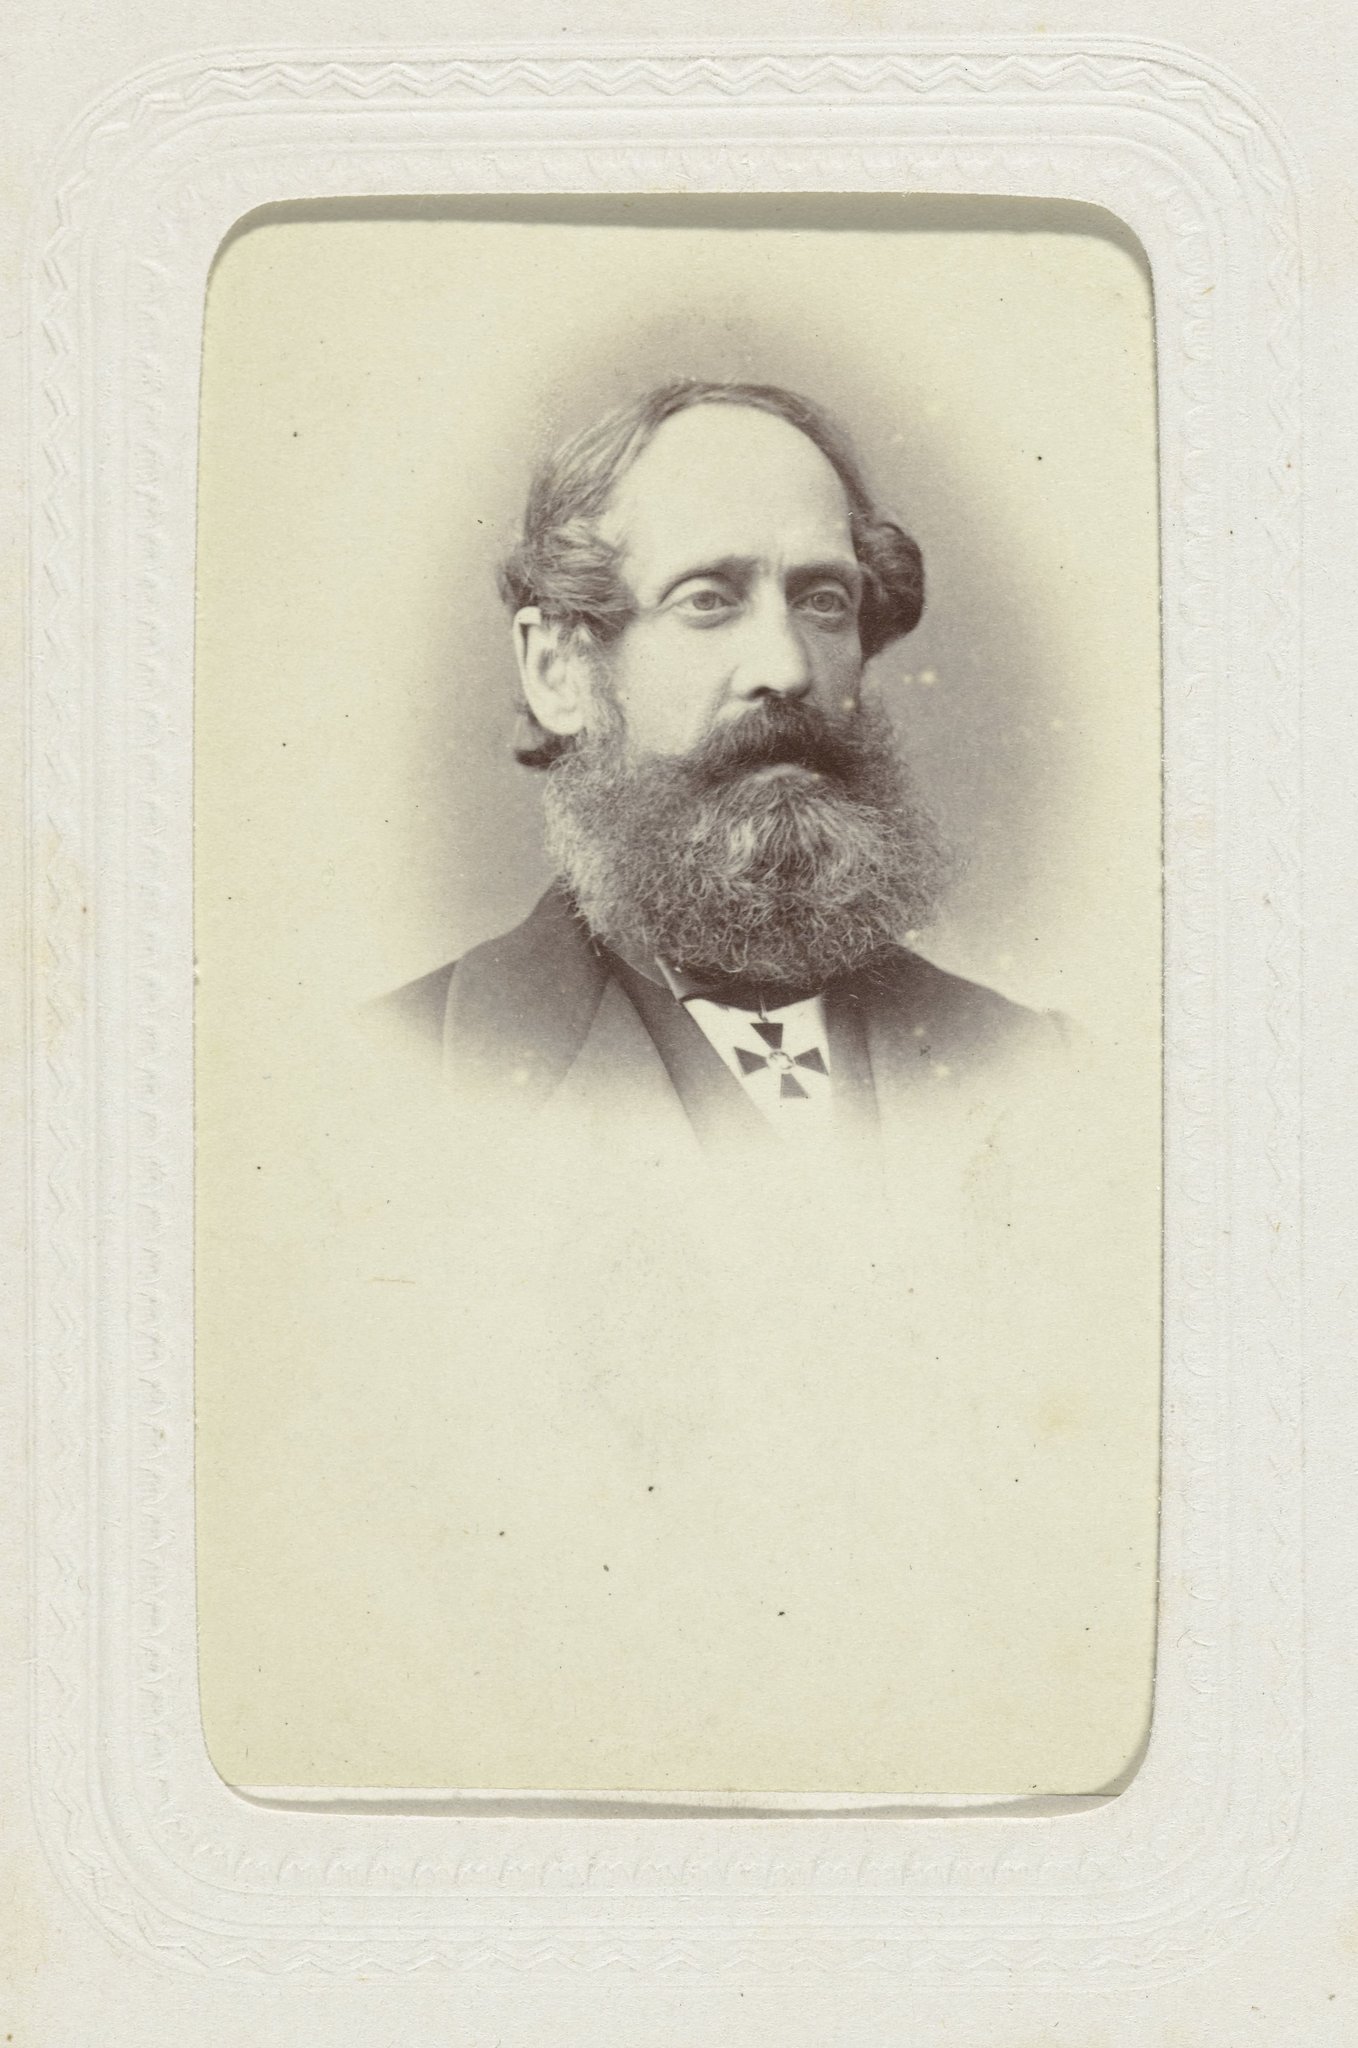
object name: carte de visite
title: Studioportret van een man met snor en baard, om zijn nek draagt hij een insigne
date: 1863-1866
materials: cardboard, paper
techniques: albumen print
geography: istanbul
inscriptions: name: ‘Abdullah freres Istanbul’, name: ‘Bykow’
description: De afgebeelde man is vermoedelijk de heer Bykow.